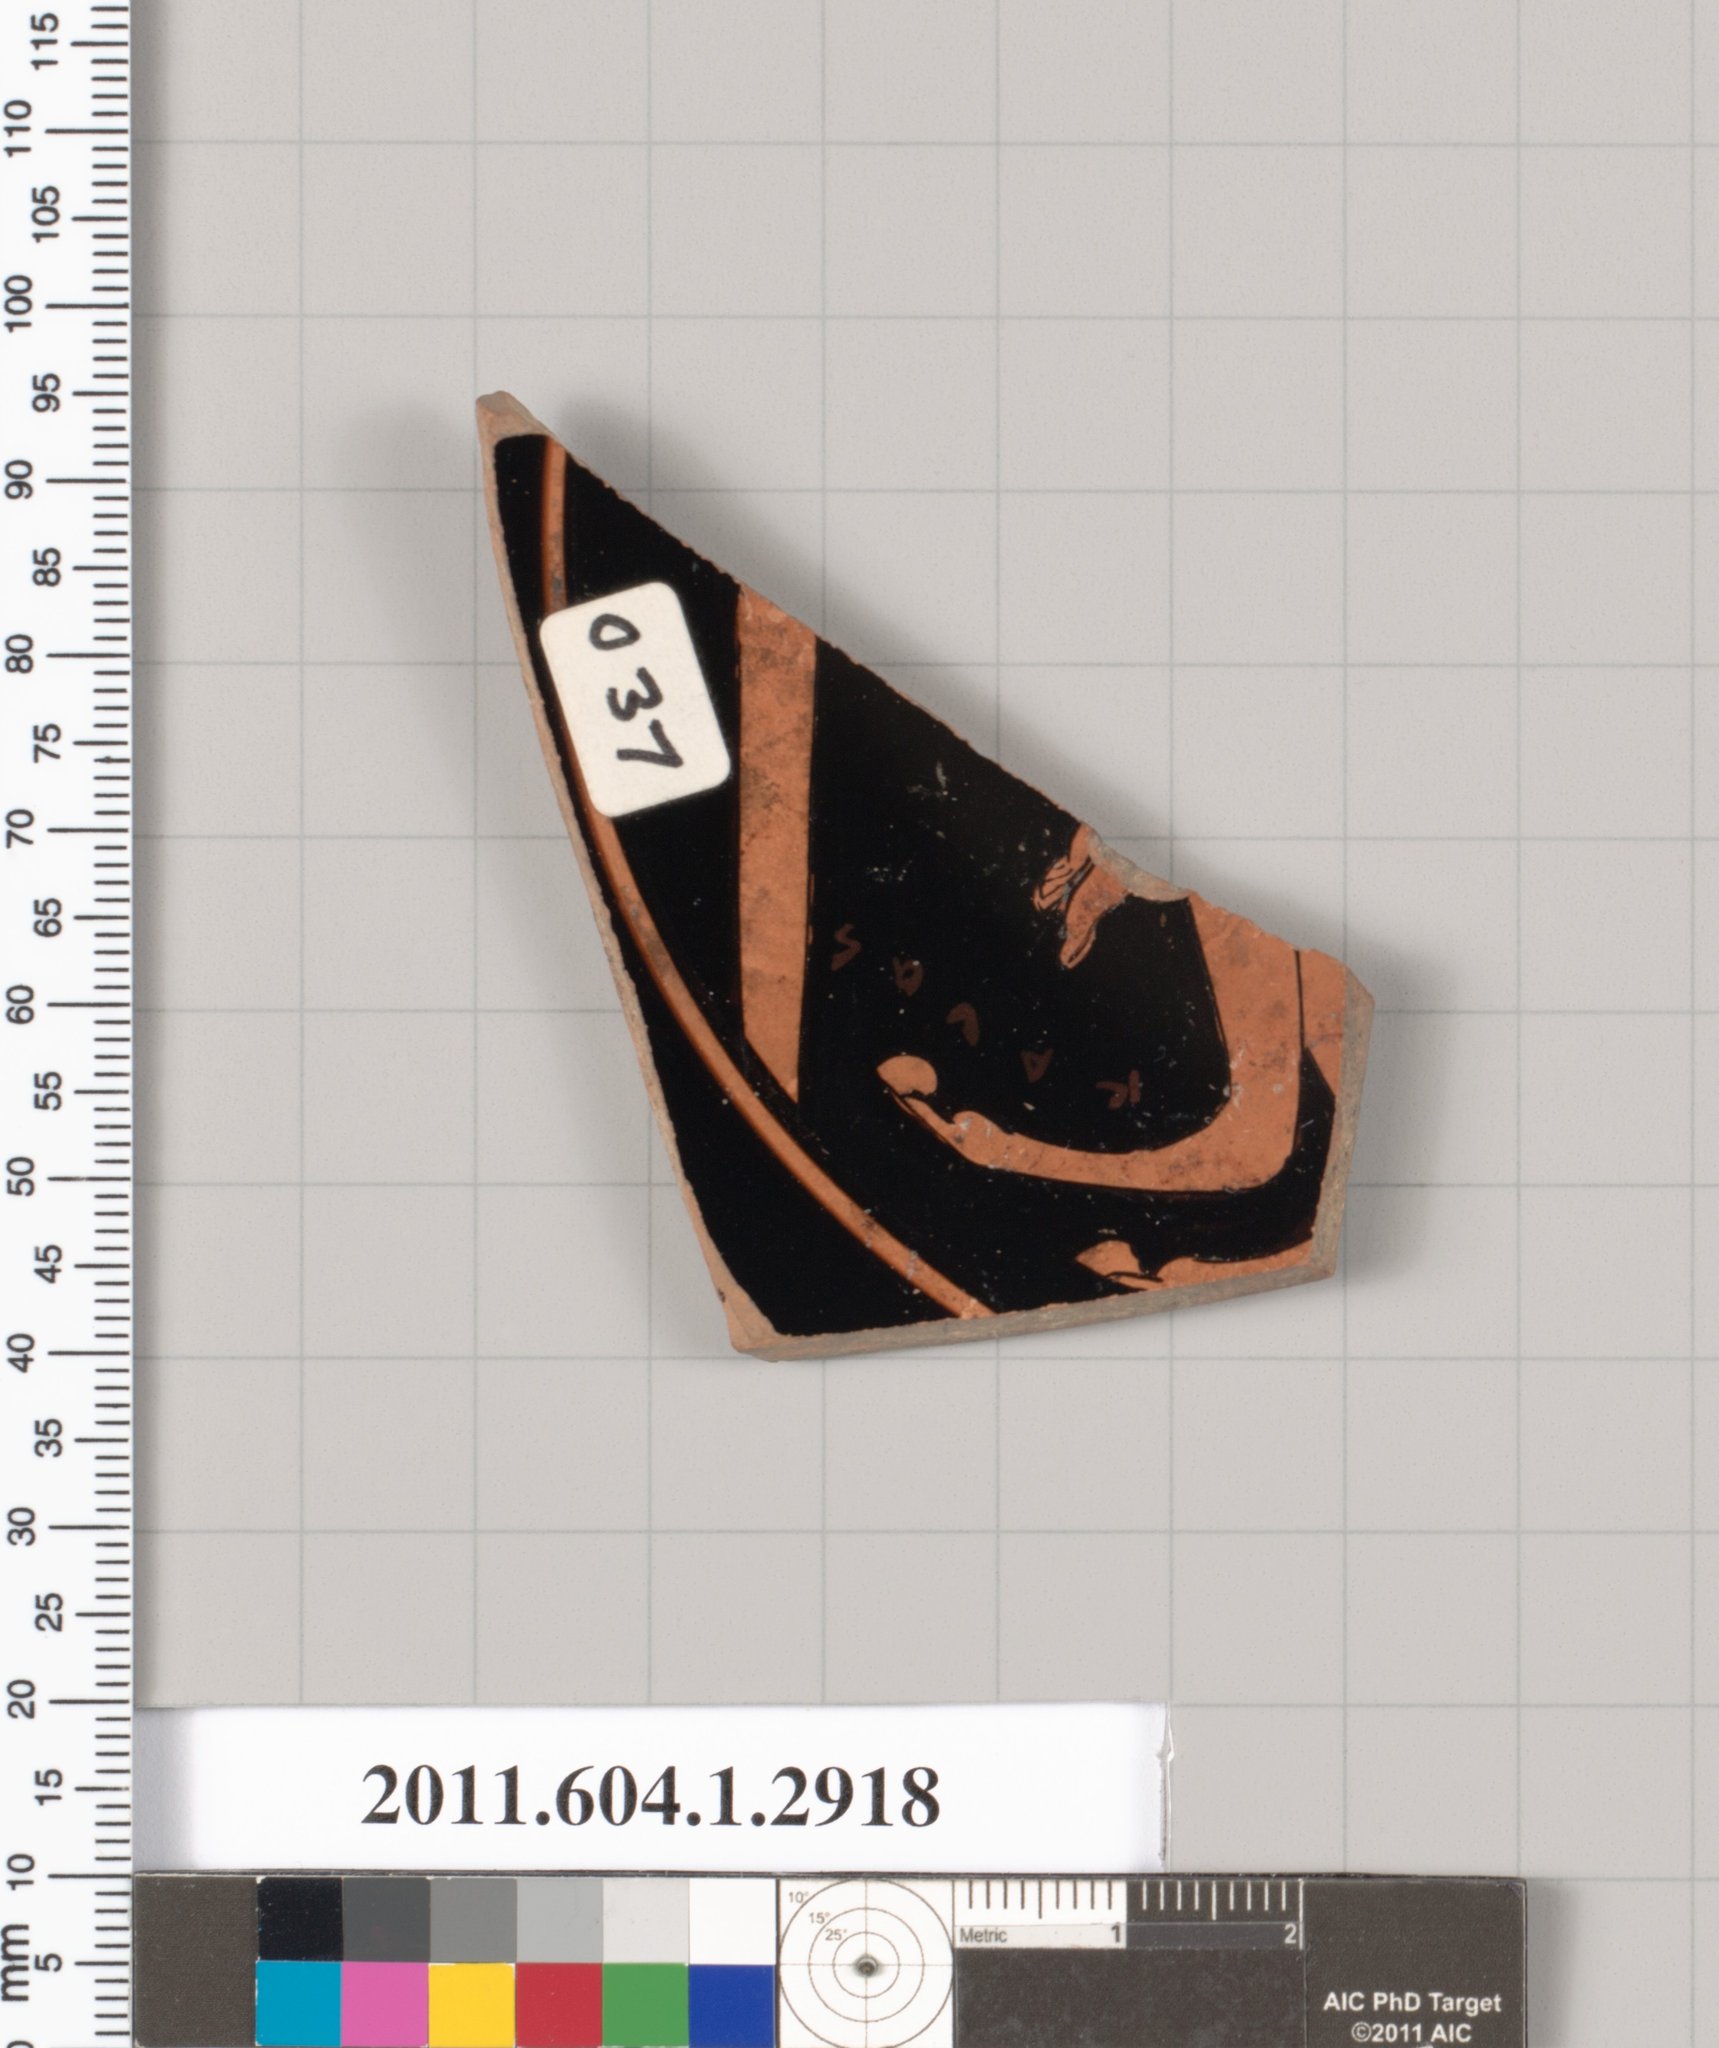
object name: kylix fragment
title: Terracotta fragment of a kylix (drinking cup)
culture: greek, attic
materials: terracotta